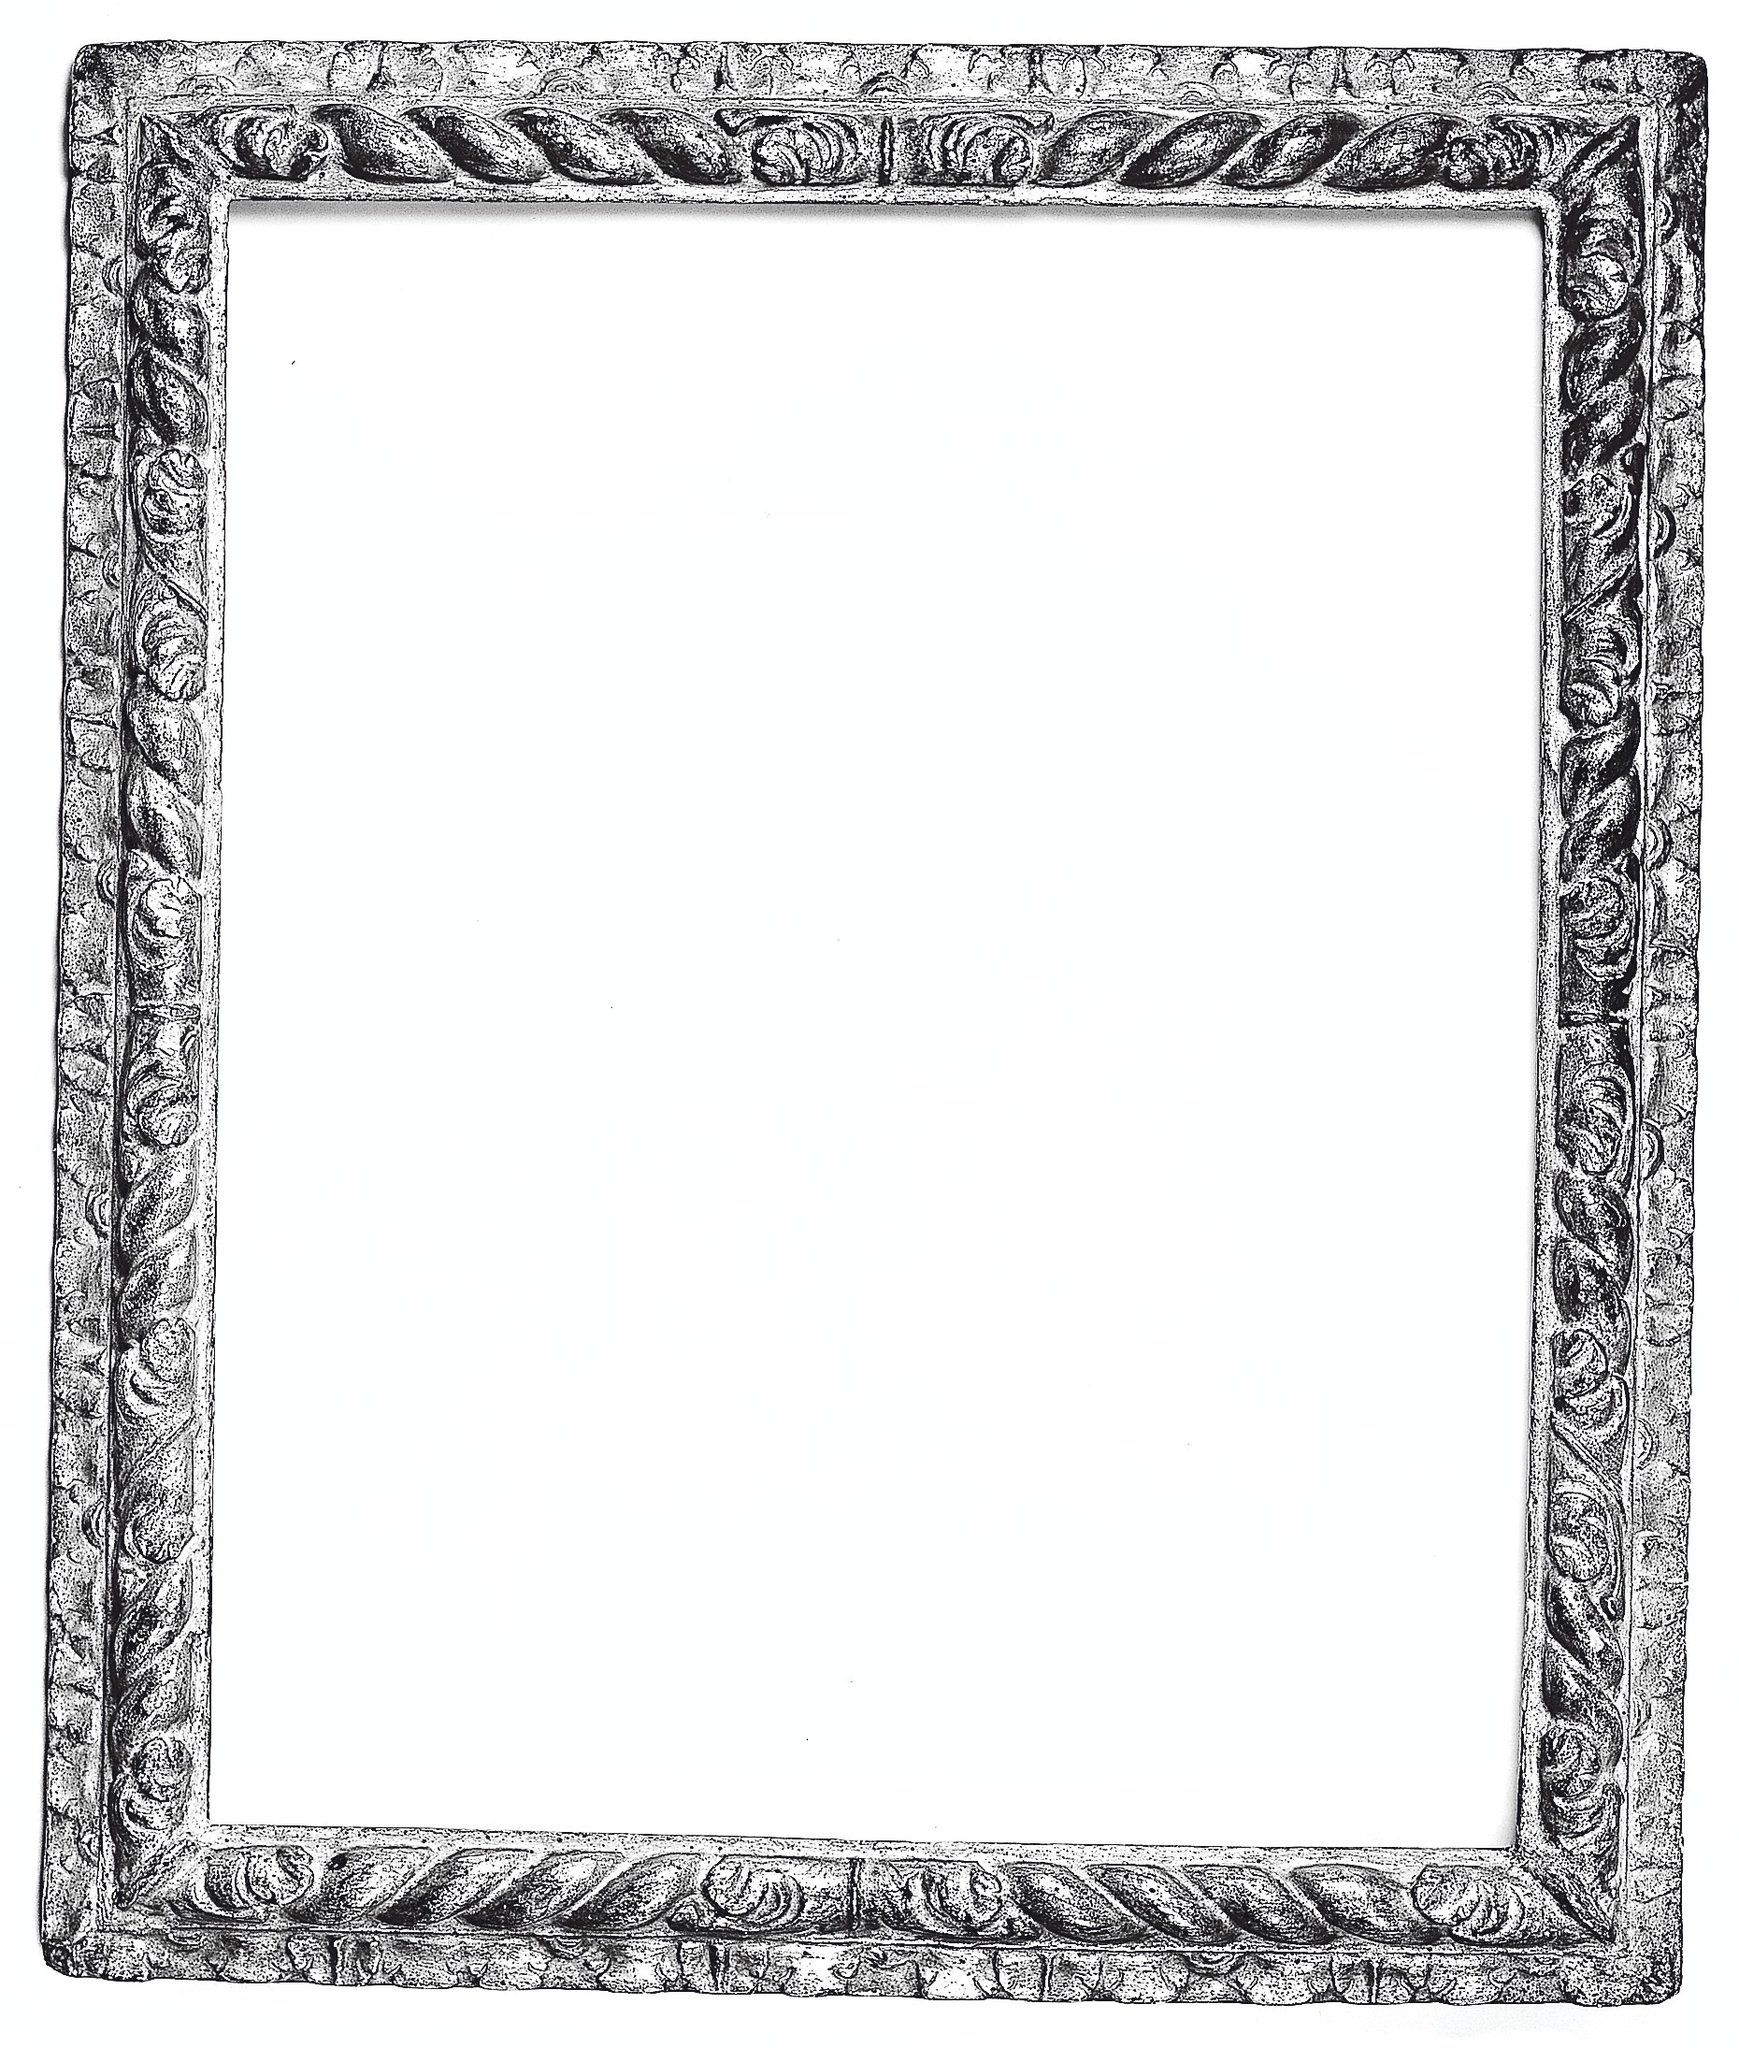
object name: frame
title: Astragal frame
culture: italian, veneto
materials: wood